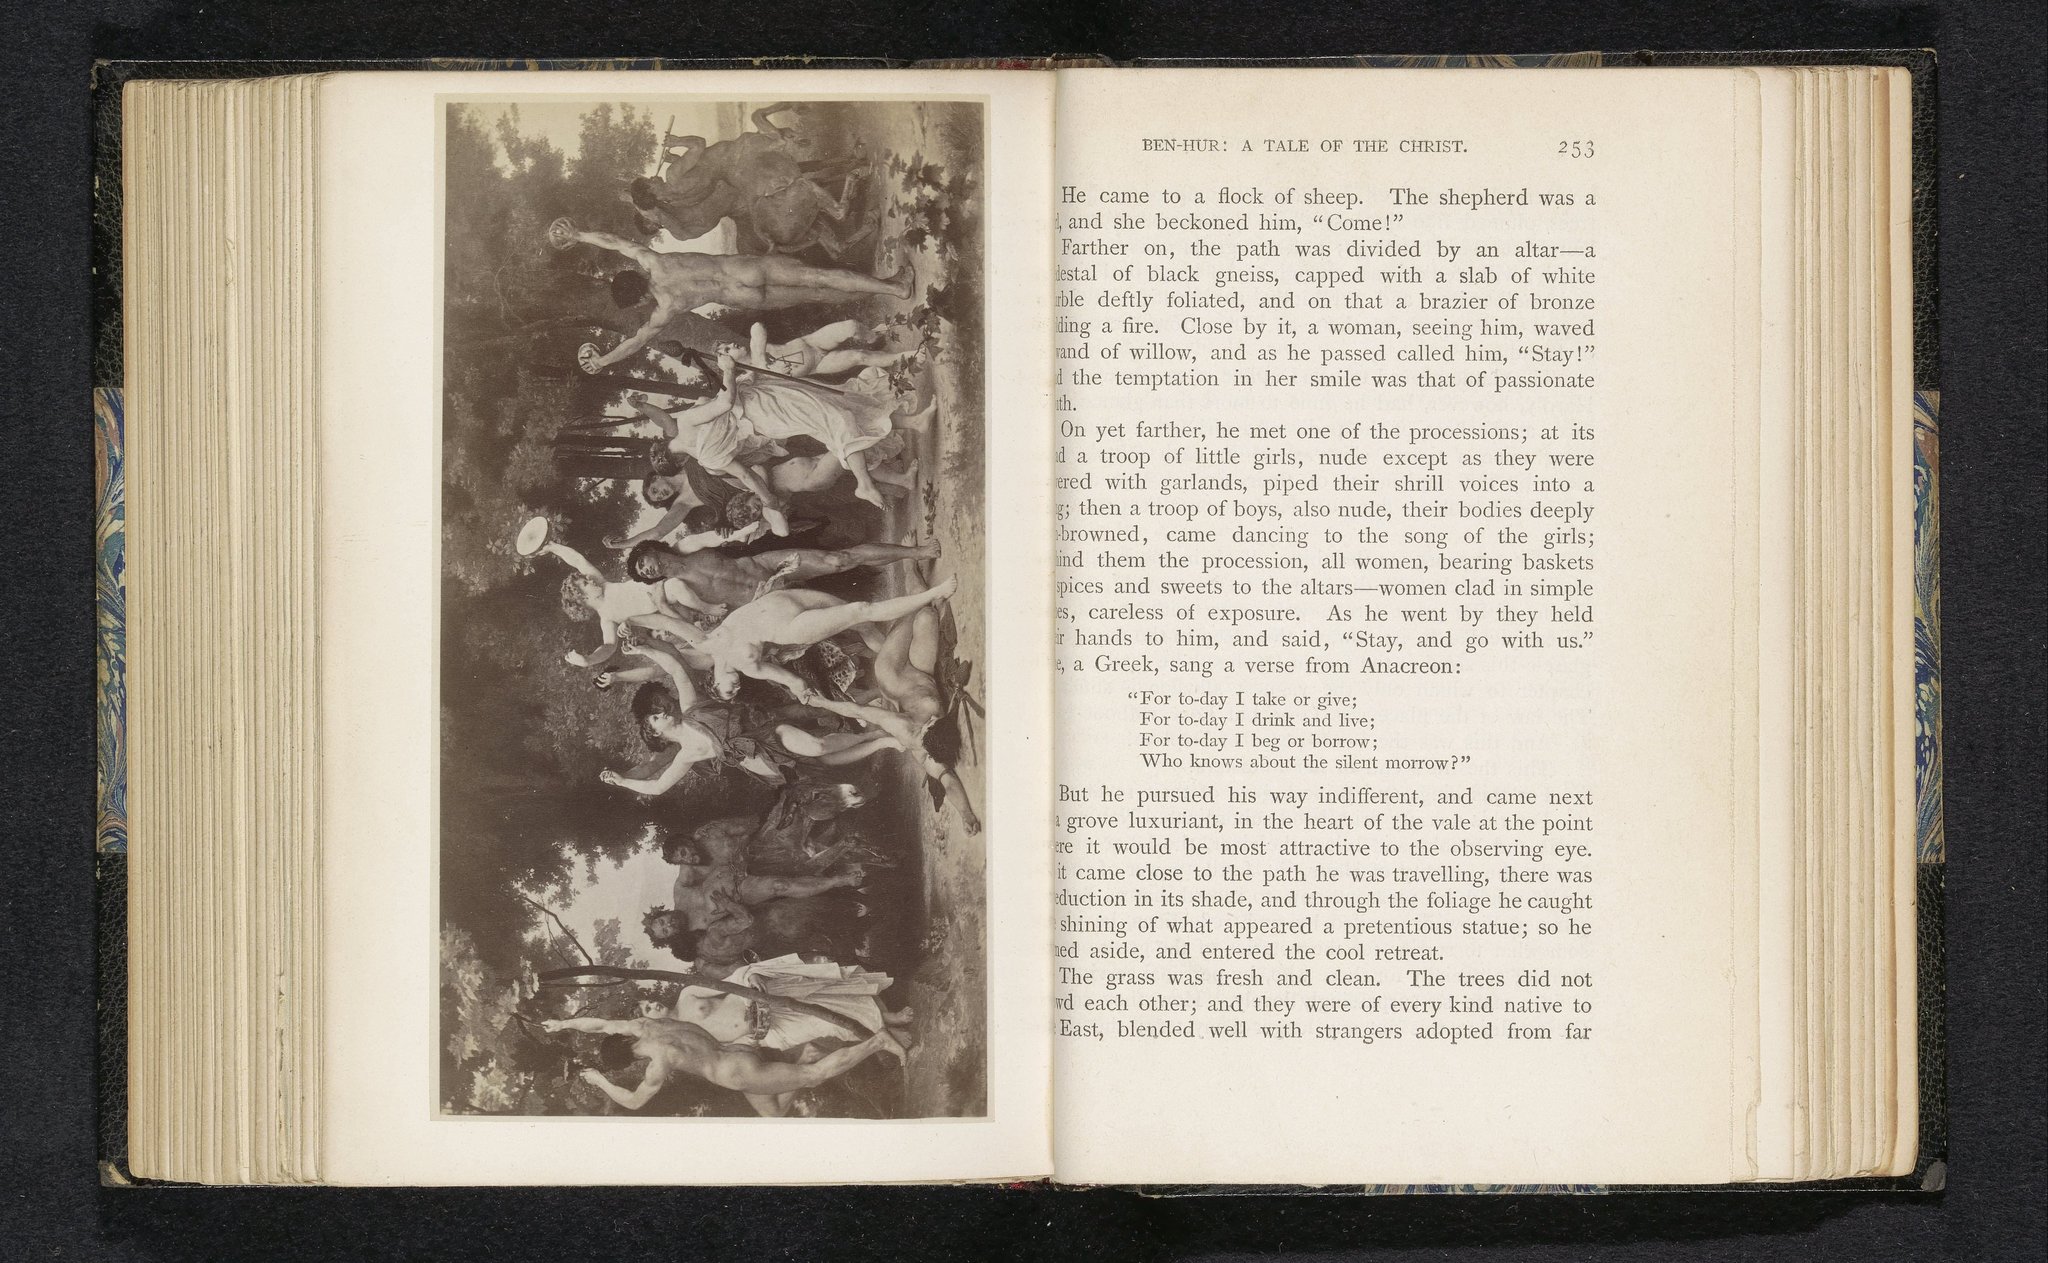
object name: reproduction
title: Fotoreproductie van een schilderij, voorstellende een processie met de jonge Bacchus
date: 1883-1888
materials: photographic support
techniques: albumen print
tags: bacchus brought up by satyrs, maenads and silenus, infancy, upbringing of bacchus